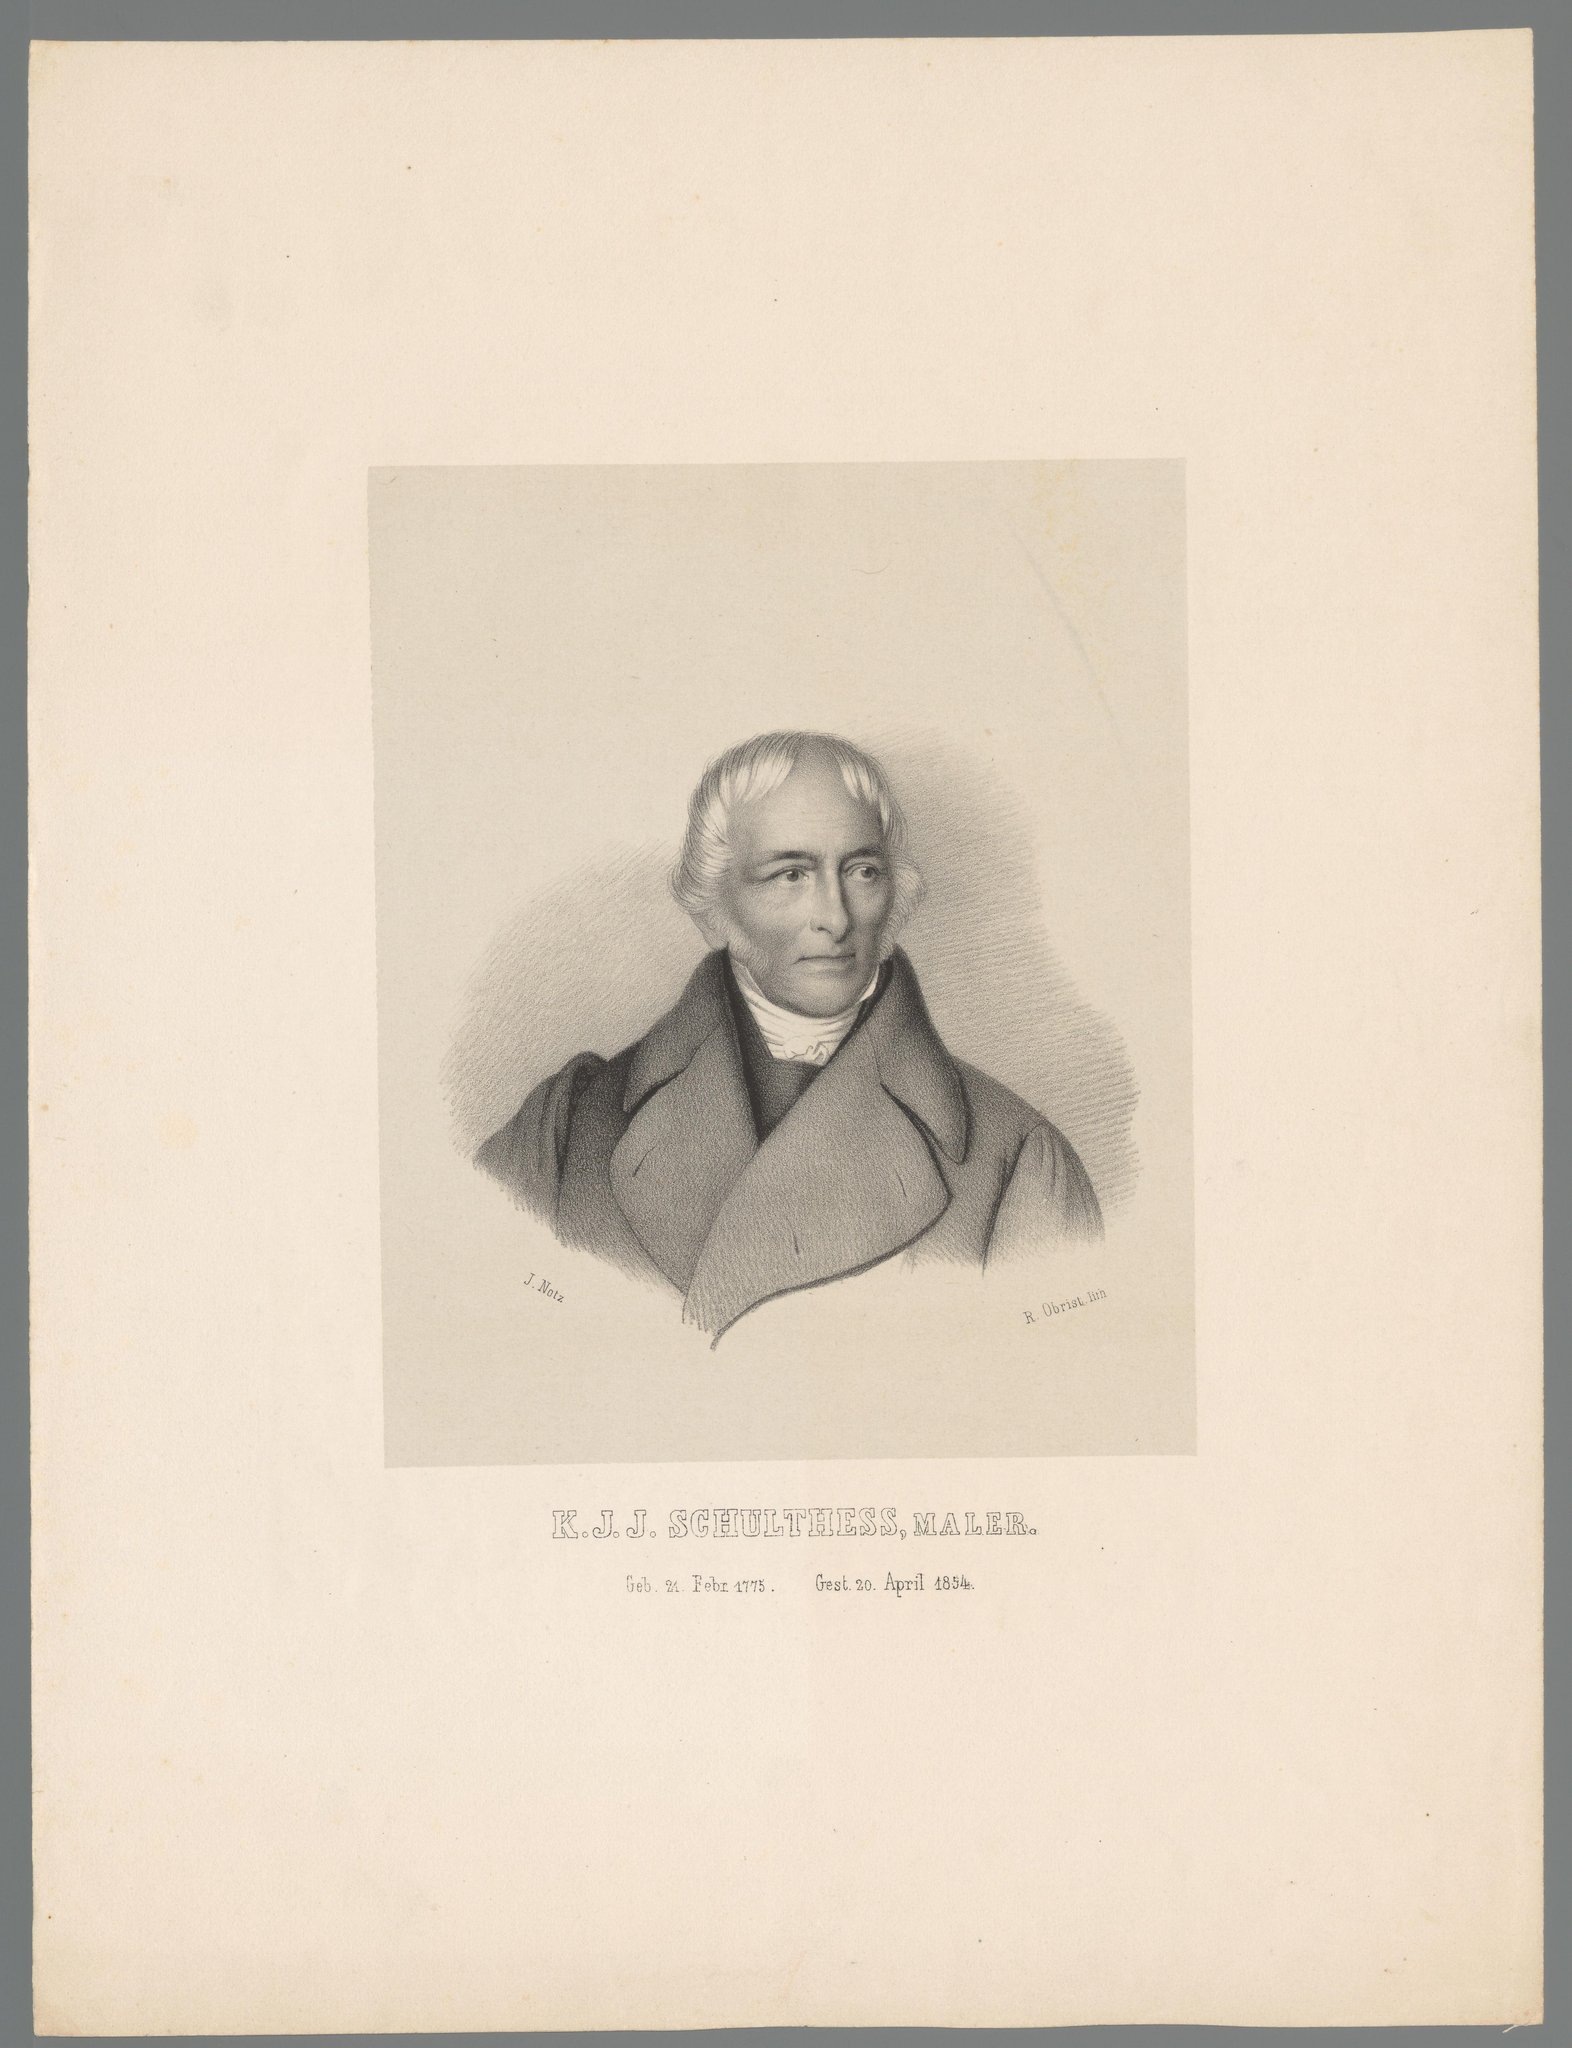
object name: print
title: Portret van Carl Johann Jakob Schulthess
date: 1854-1875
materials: paper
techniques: lithograph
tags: draughtsman, carl johann jakob schulthess, adult man, historical persons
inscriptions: collector's mark: Lugt 2228